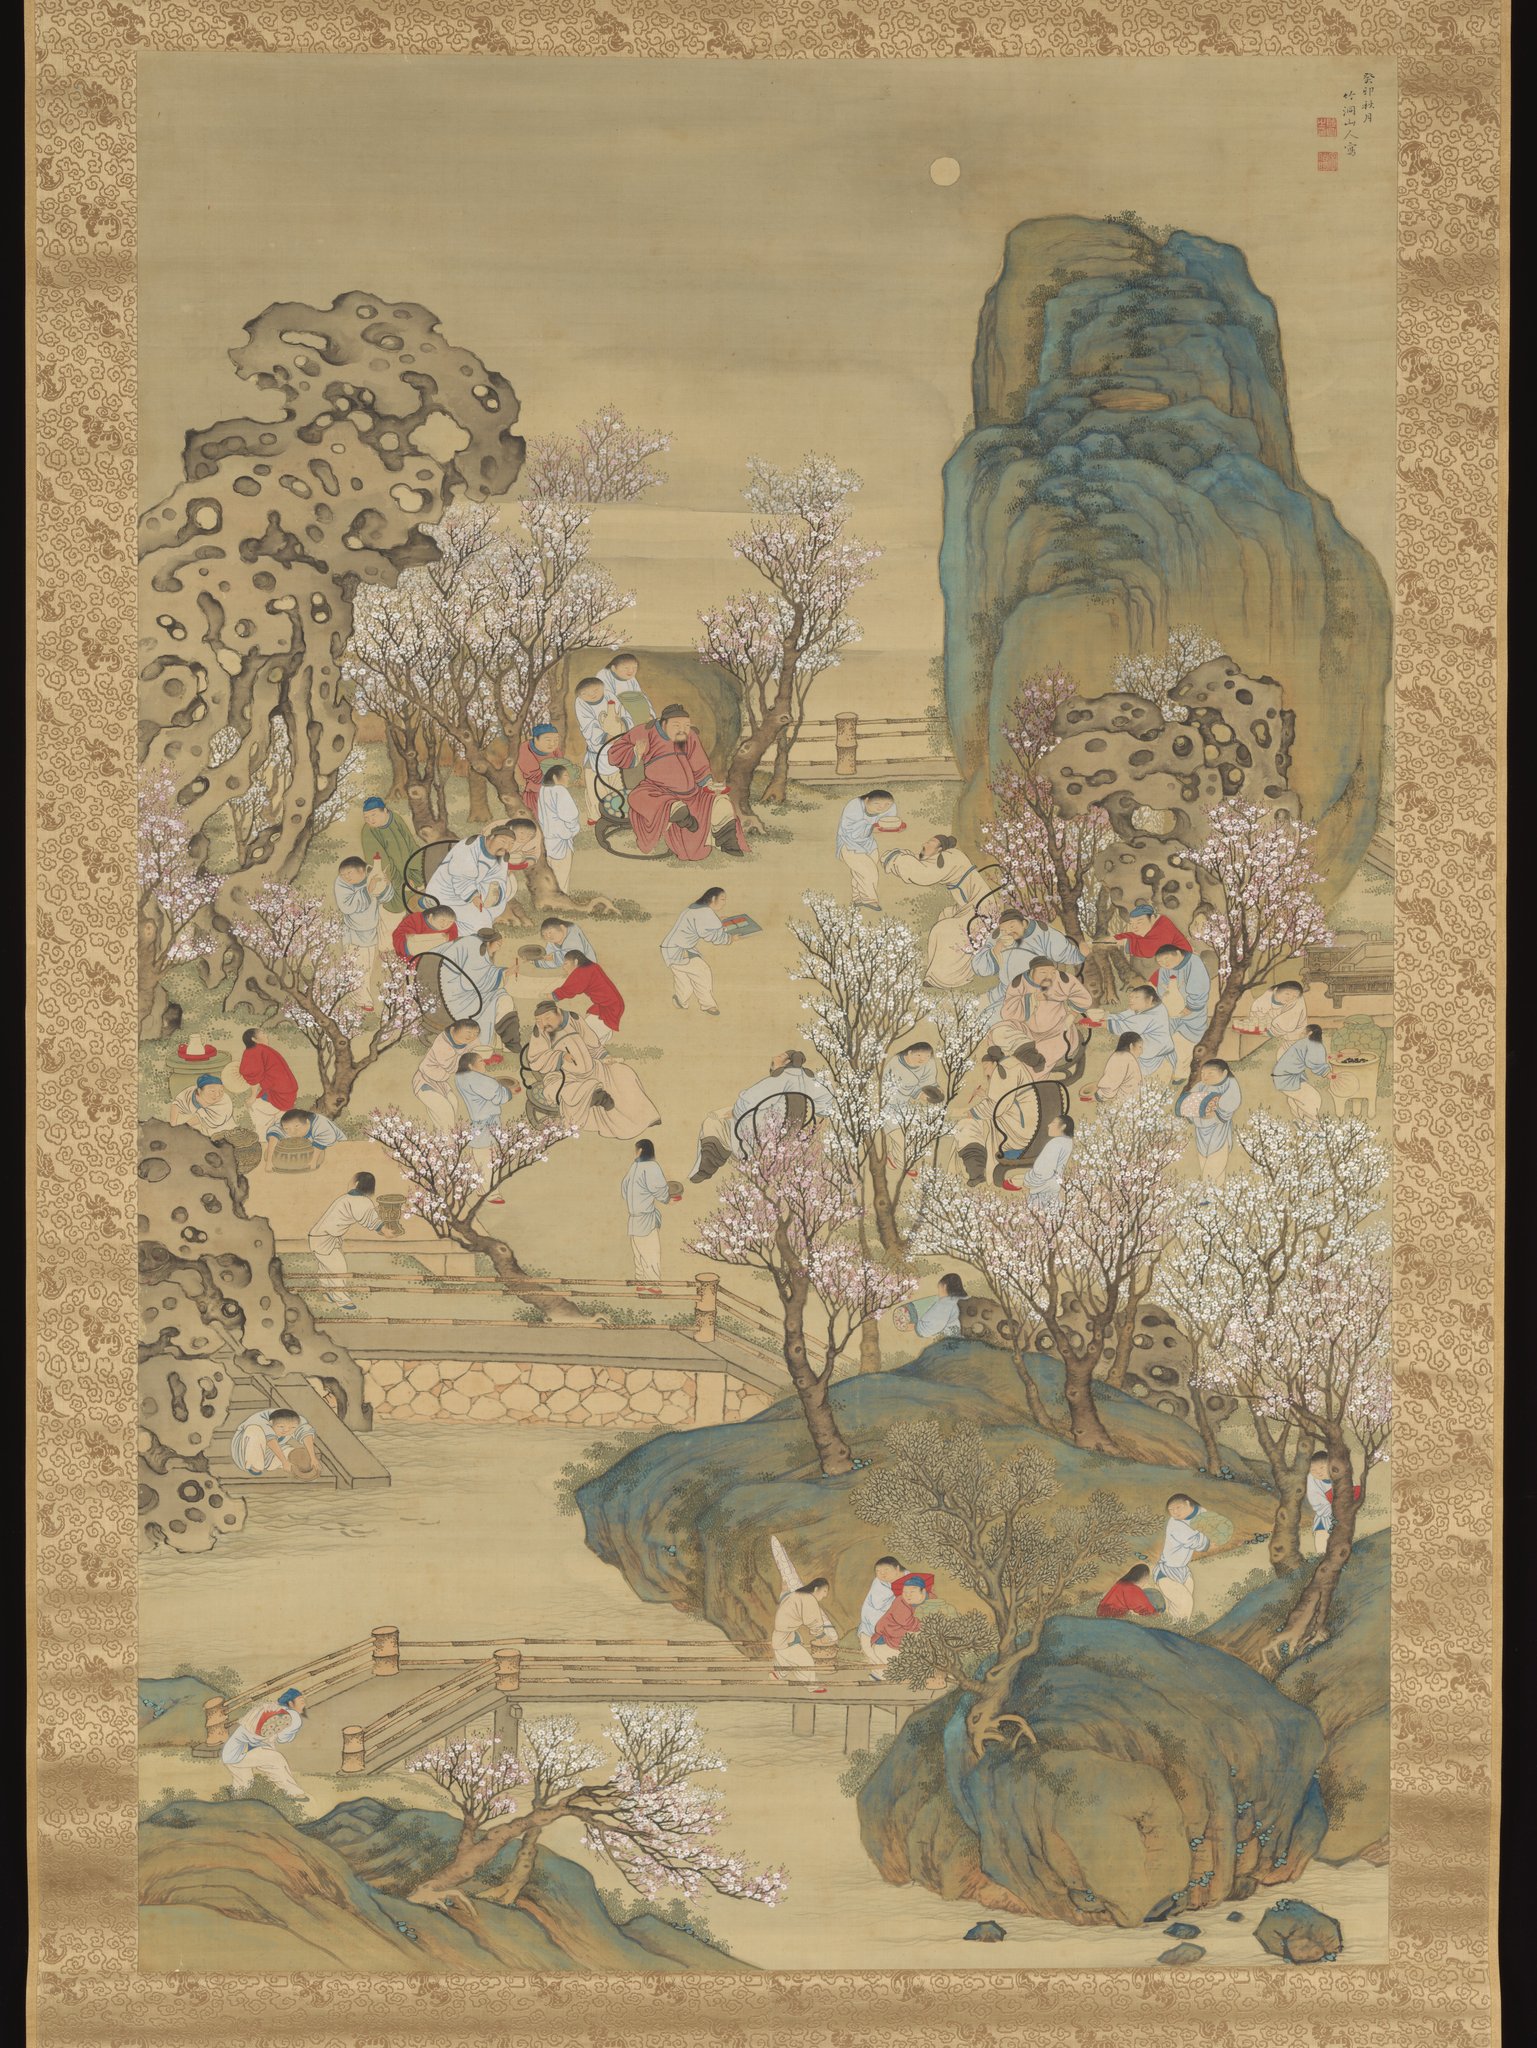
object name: hanging scroll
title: Fragrant Garden under a Hazy Moon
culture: japanese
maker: nakabayashi chikutō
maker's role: artist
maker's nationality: japanese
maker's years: 1776-1853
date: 1843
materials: ink, silk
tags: gardens,boys,men